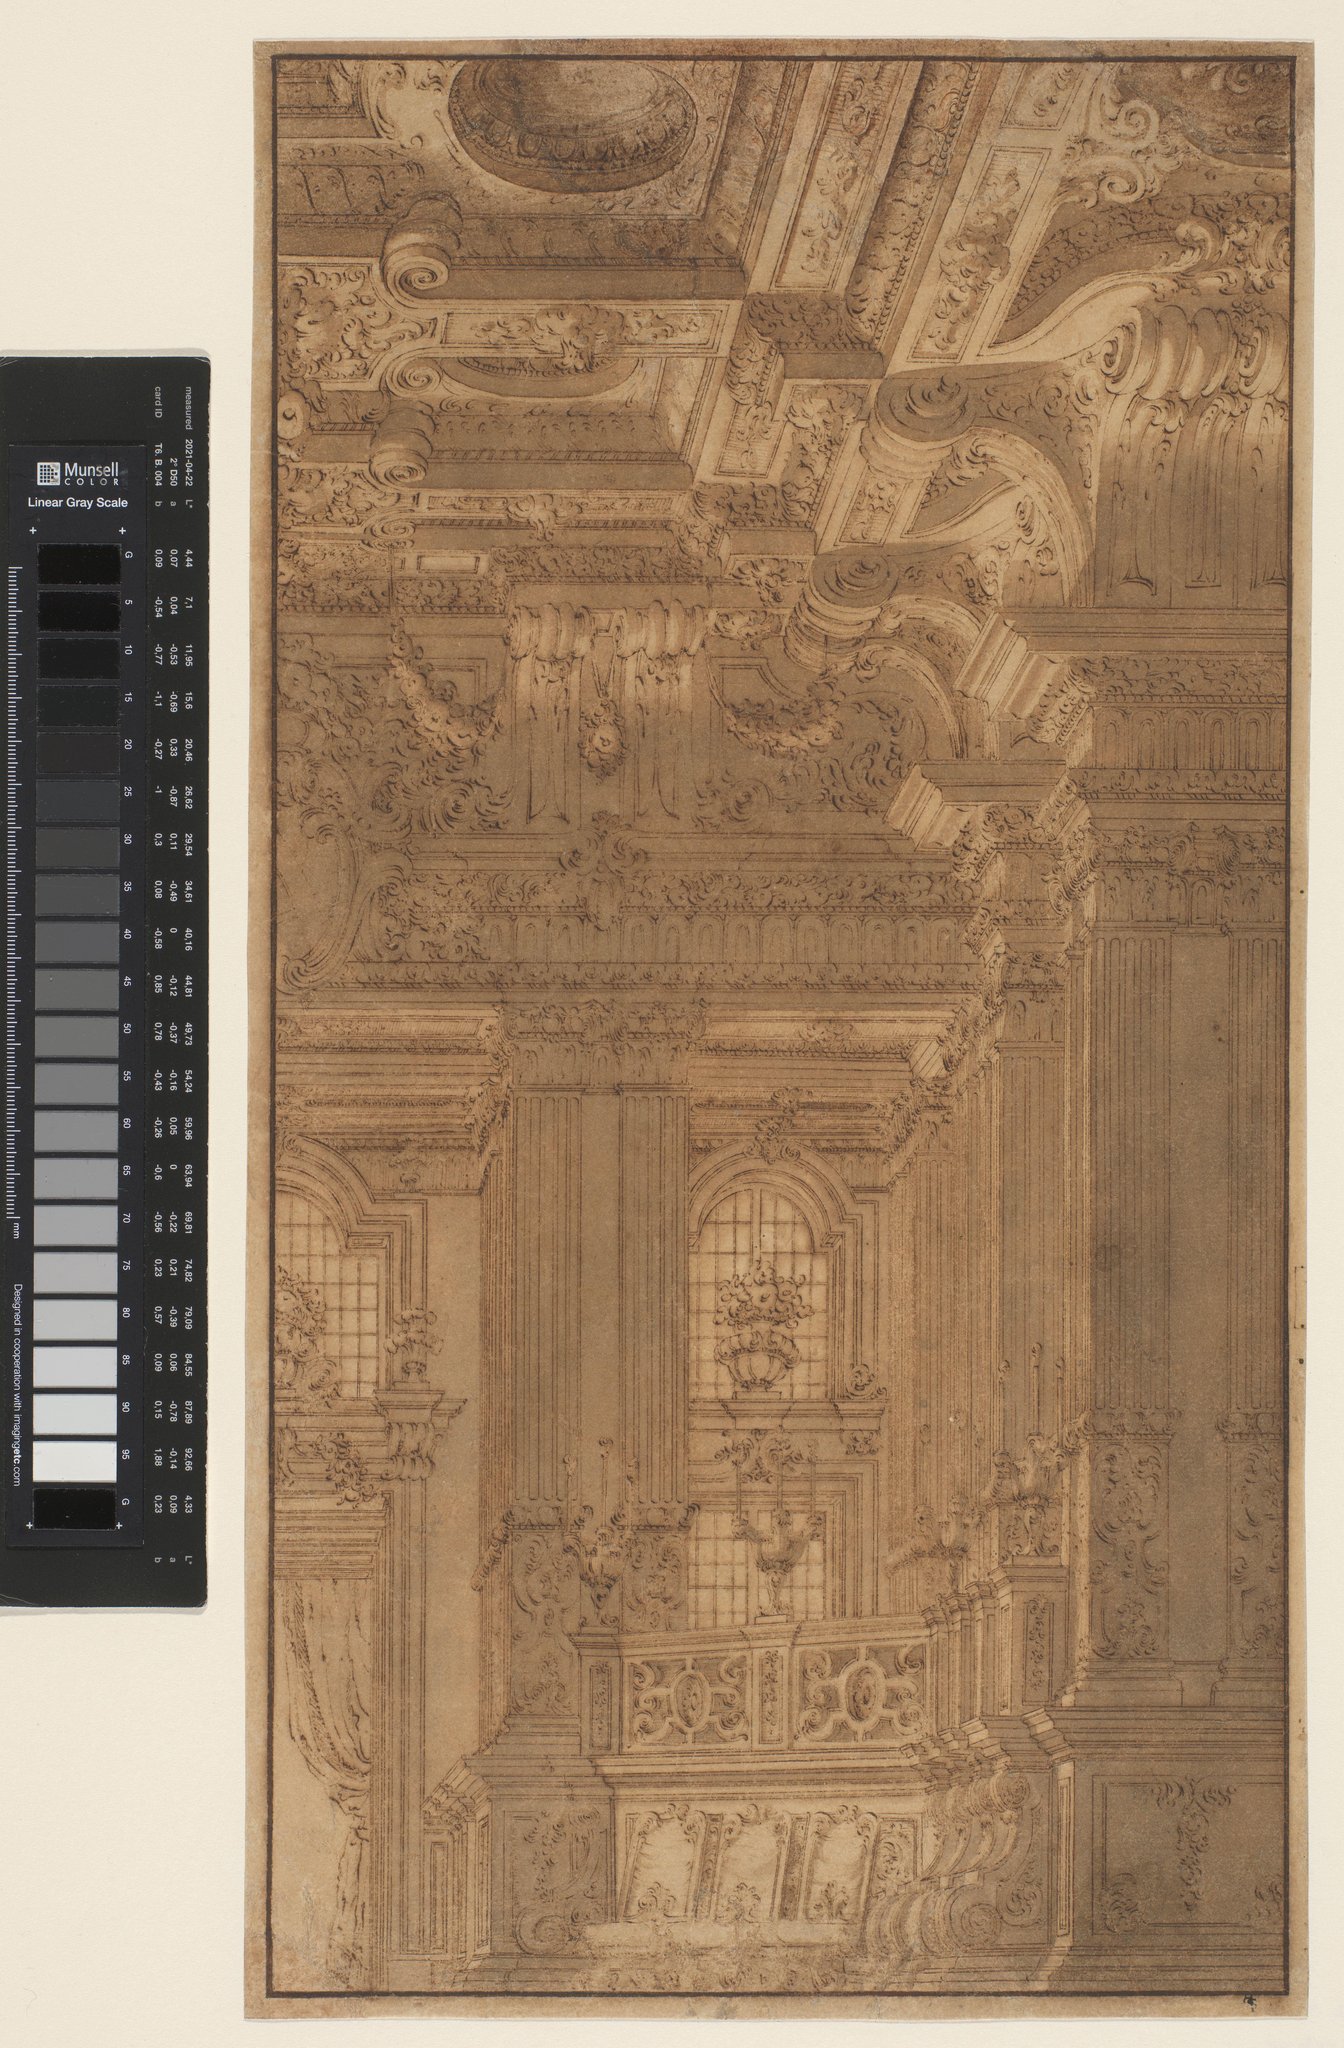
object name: architectuurtekening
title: Interieur van een rijk versierde kerk of paleis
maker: jean lepautre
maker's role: draughtsman, print maker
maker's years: 1618-1682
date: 1628-1682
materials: ink, paper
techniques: brush, pen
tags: interior of church